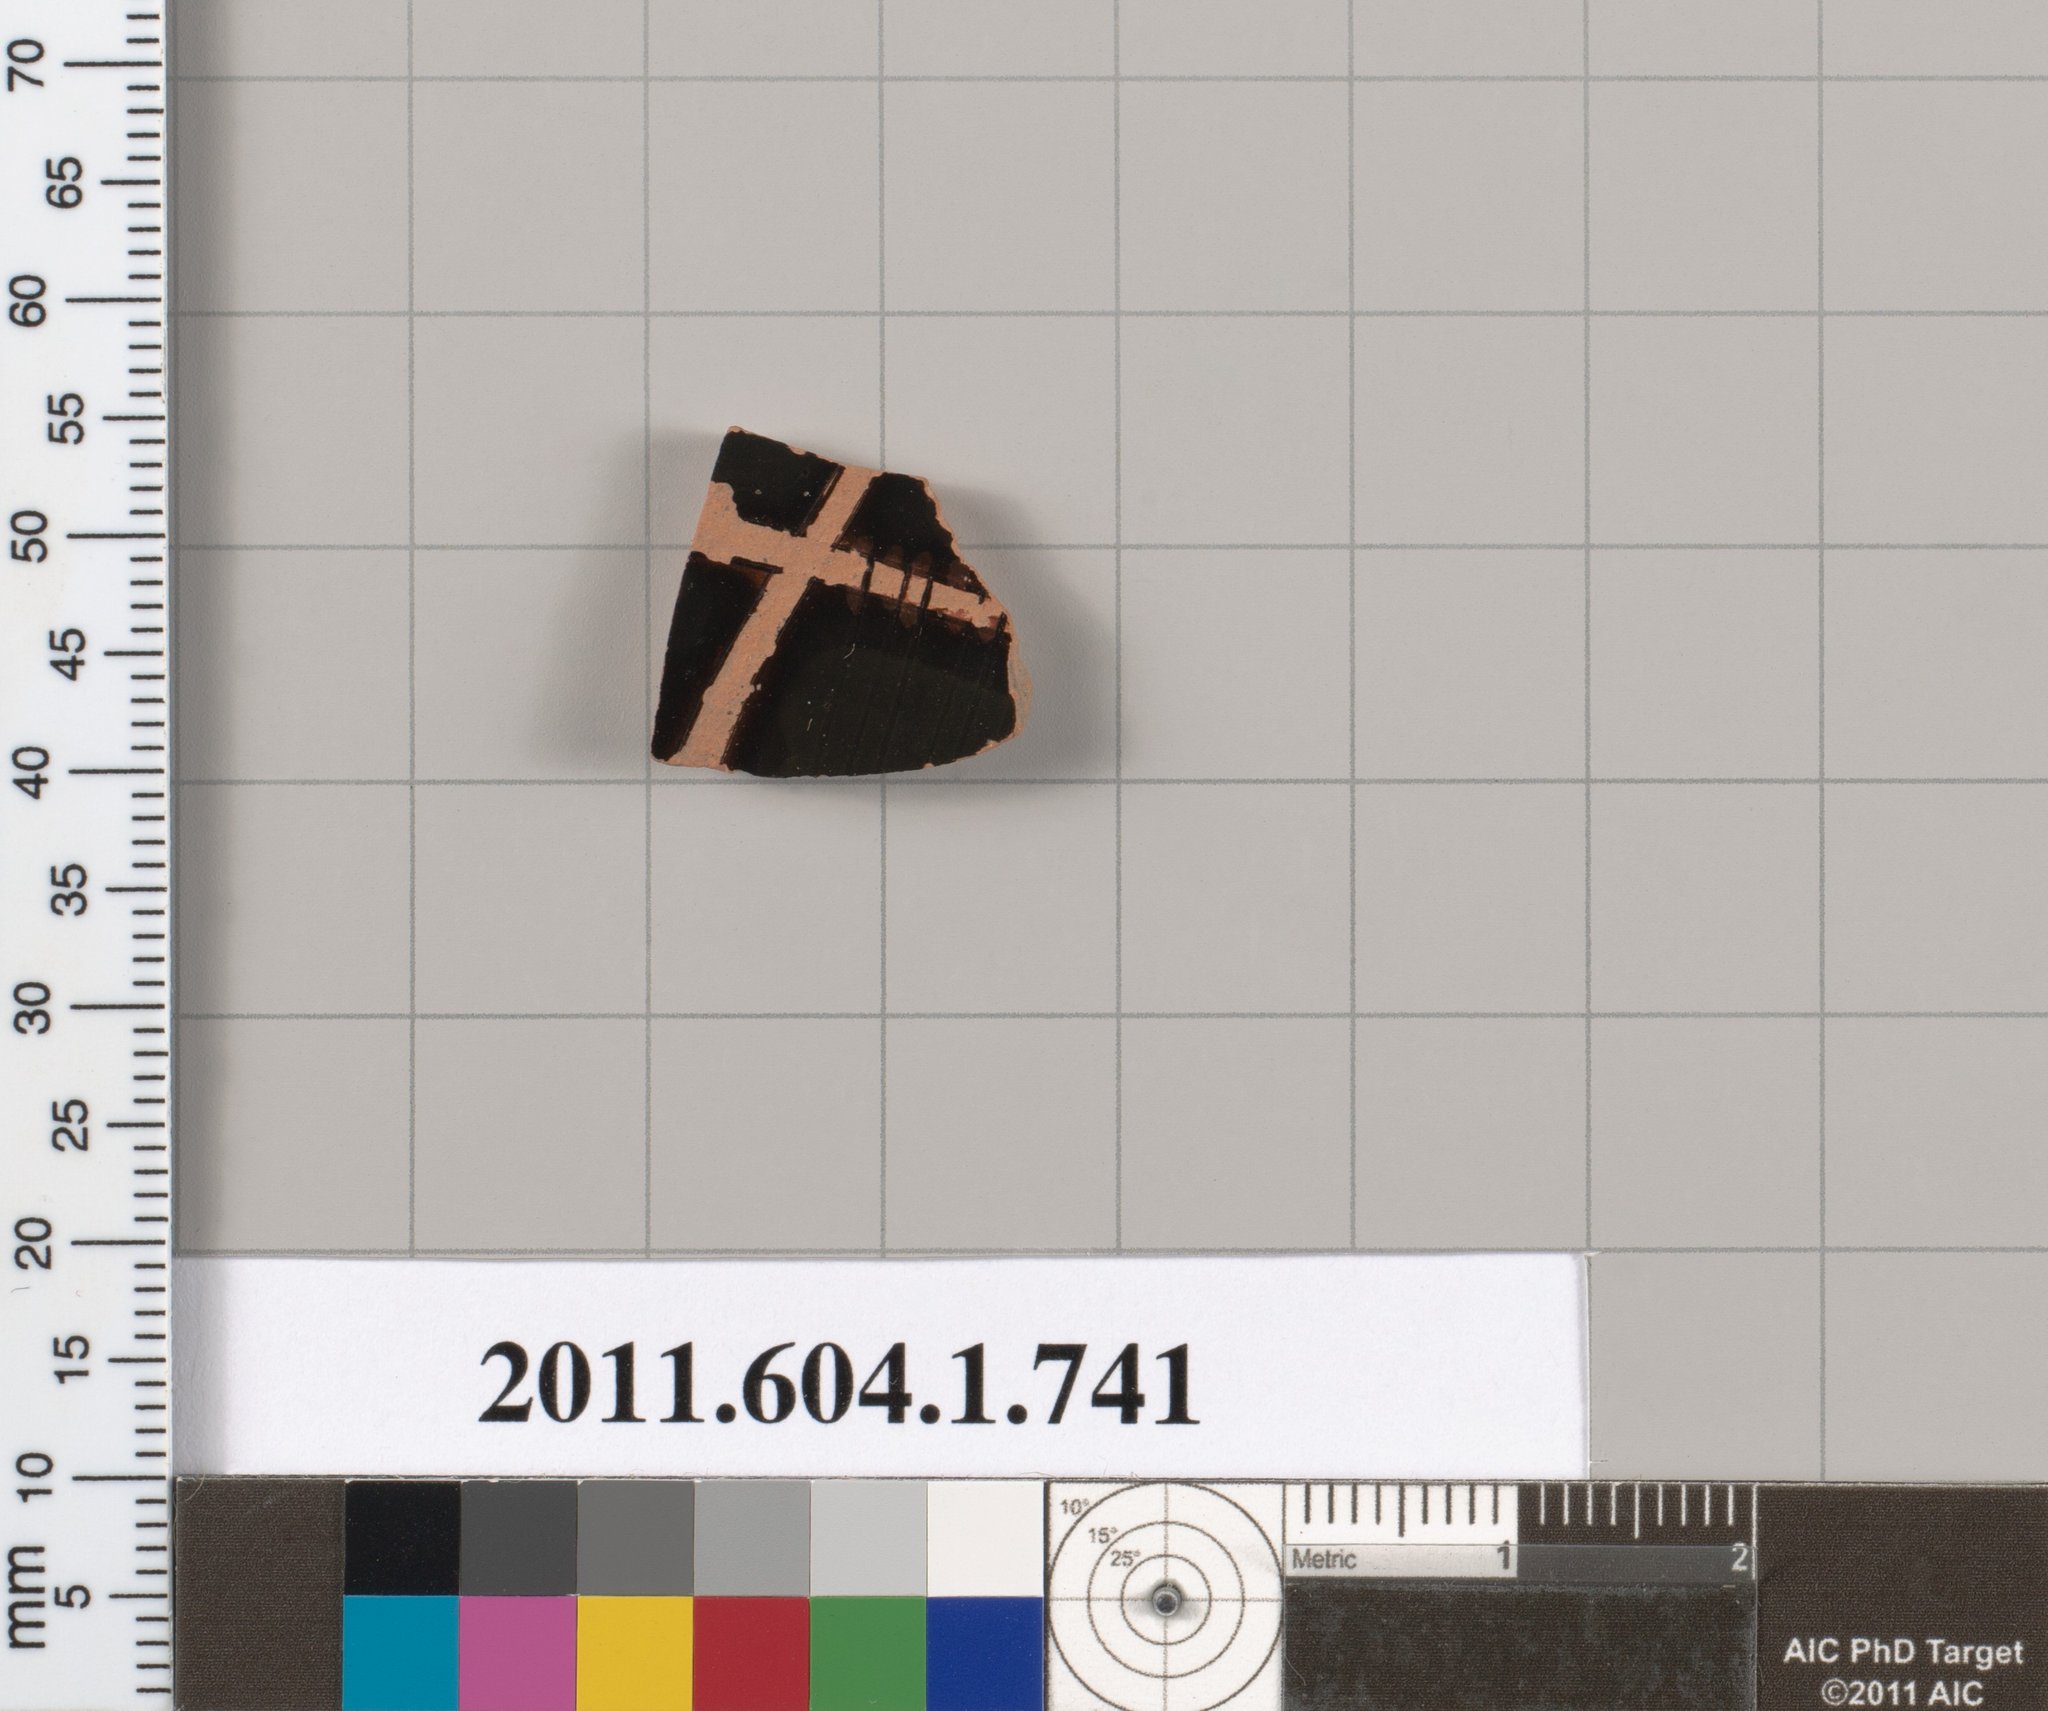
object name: kylix fragment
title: Terracotta fragment of a kylix (drinking cup)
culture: greek, attic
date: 490 BCE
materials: terracotta